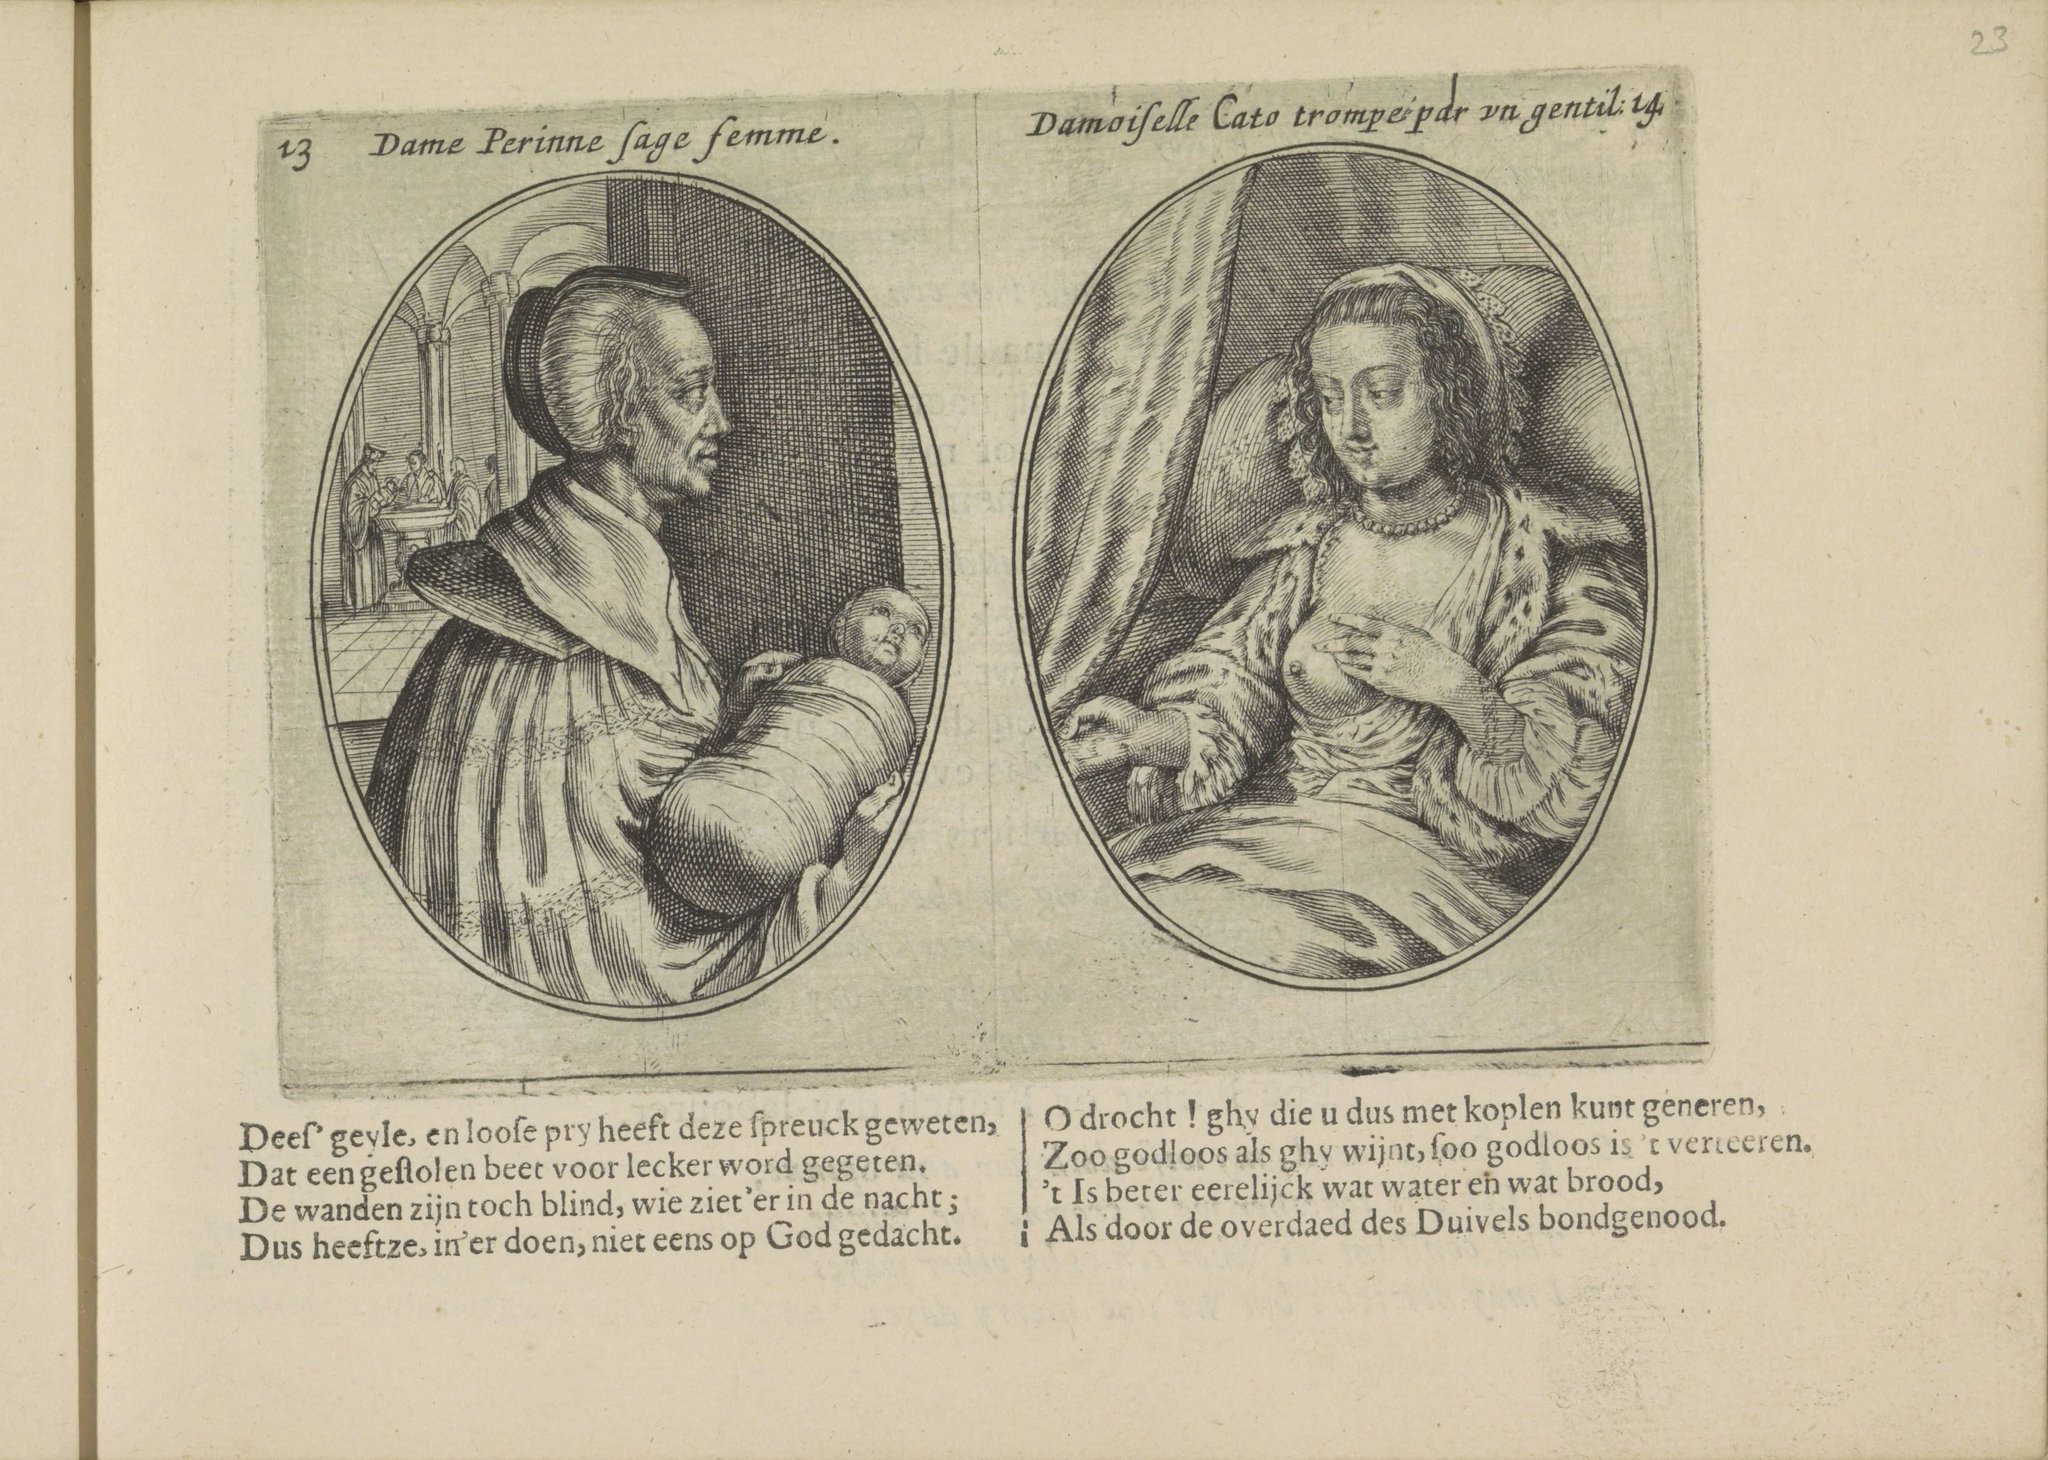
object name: print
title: Dame Perinne sage femme / Damoiselle Cato tromper par un gentil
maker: crispijn van de passe (ii)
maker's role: draughtsman, print maker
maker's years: 1594-1670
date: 1641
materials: paper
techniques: engraving, letterpress printing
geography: amsterdam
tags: nursing, suckling, baptism, christening ceremony ~ the first of the seven sacraments, female sex; woman, midwife, 'accoucheuse', dry-nurse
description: Twee voorstellingen op een albumblad. Links het fictieve portret van een vroedvrouw genaamd Perijntge met een ingebakerd kind in haar armen. Op de achtergrond een kerkinterieur met een doopplechtigheid. Rechts ligt juffrouw Katelijn (of Cato) in bed, klaar om haar kind de borst te geven. Daaronder twee kwatrijnen in het Nederlands. De prent maakt deel uit van een album.